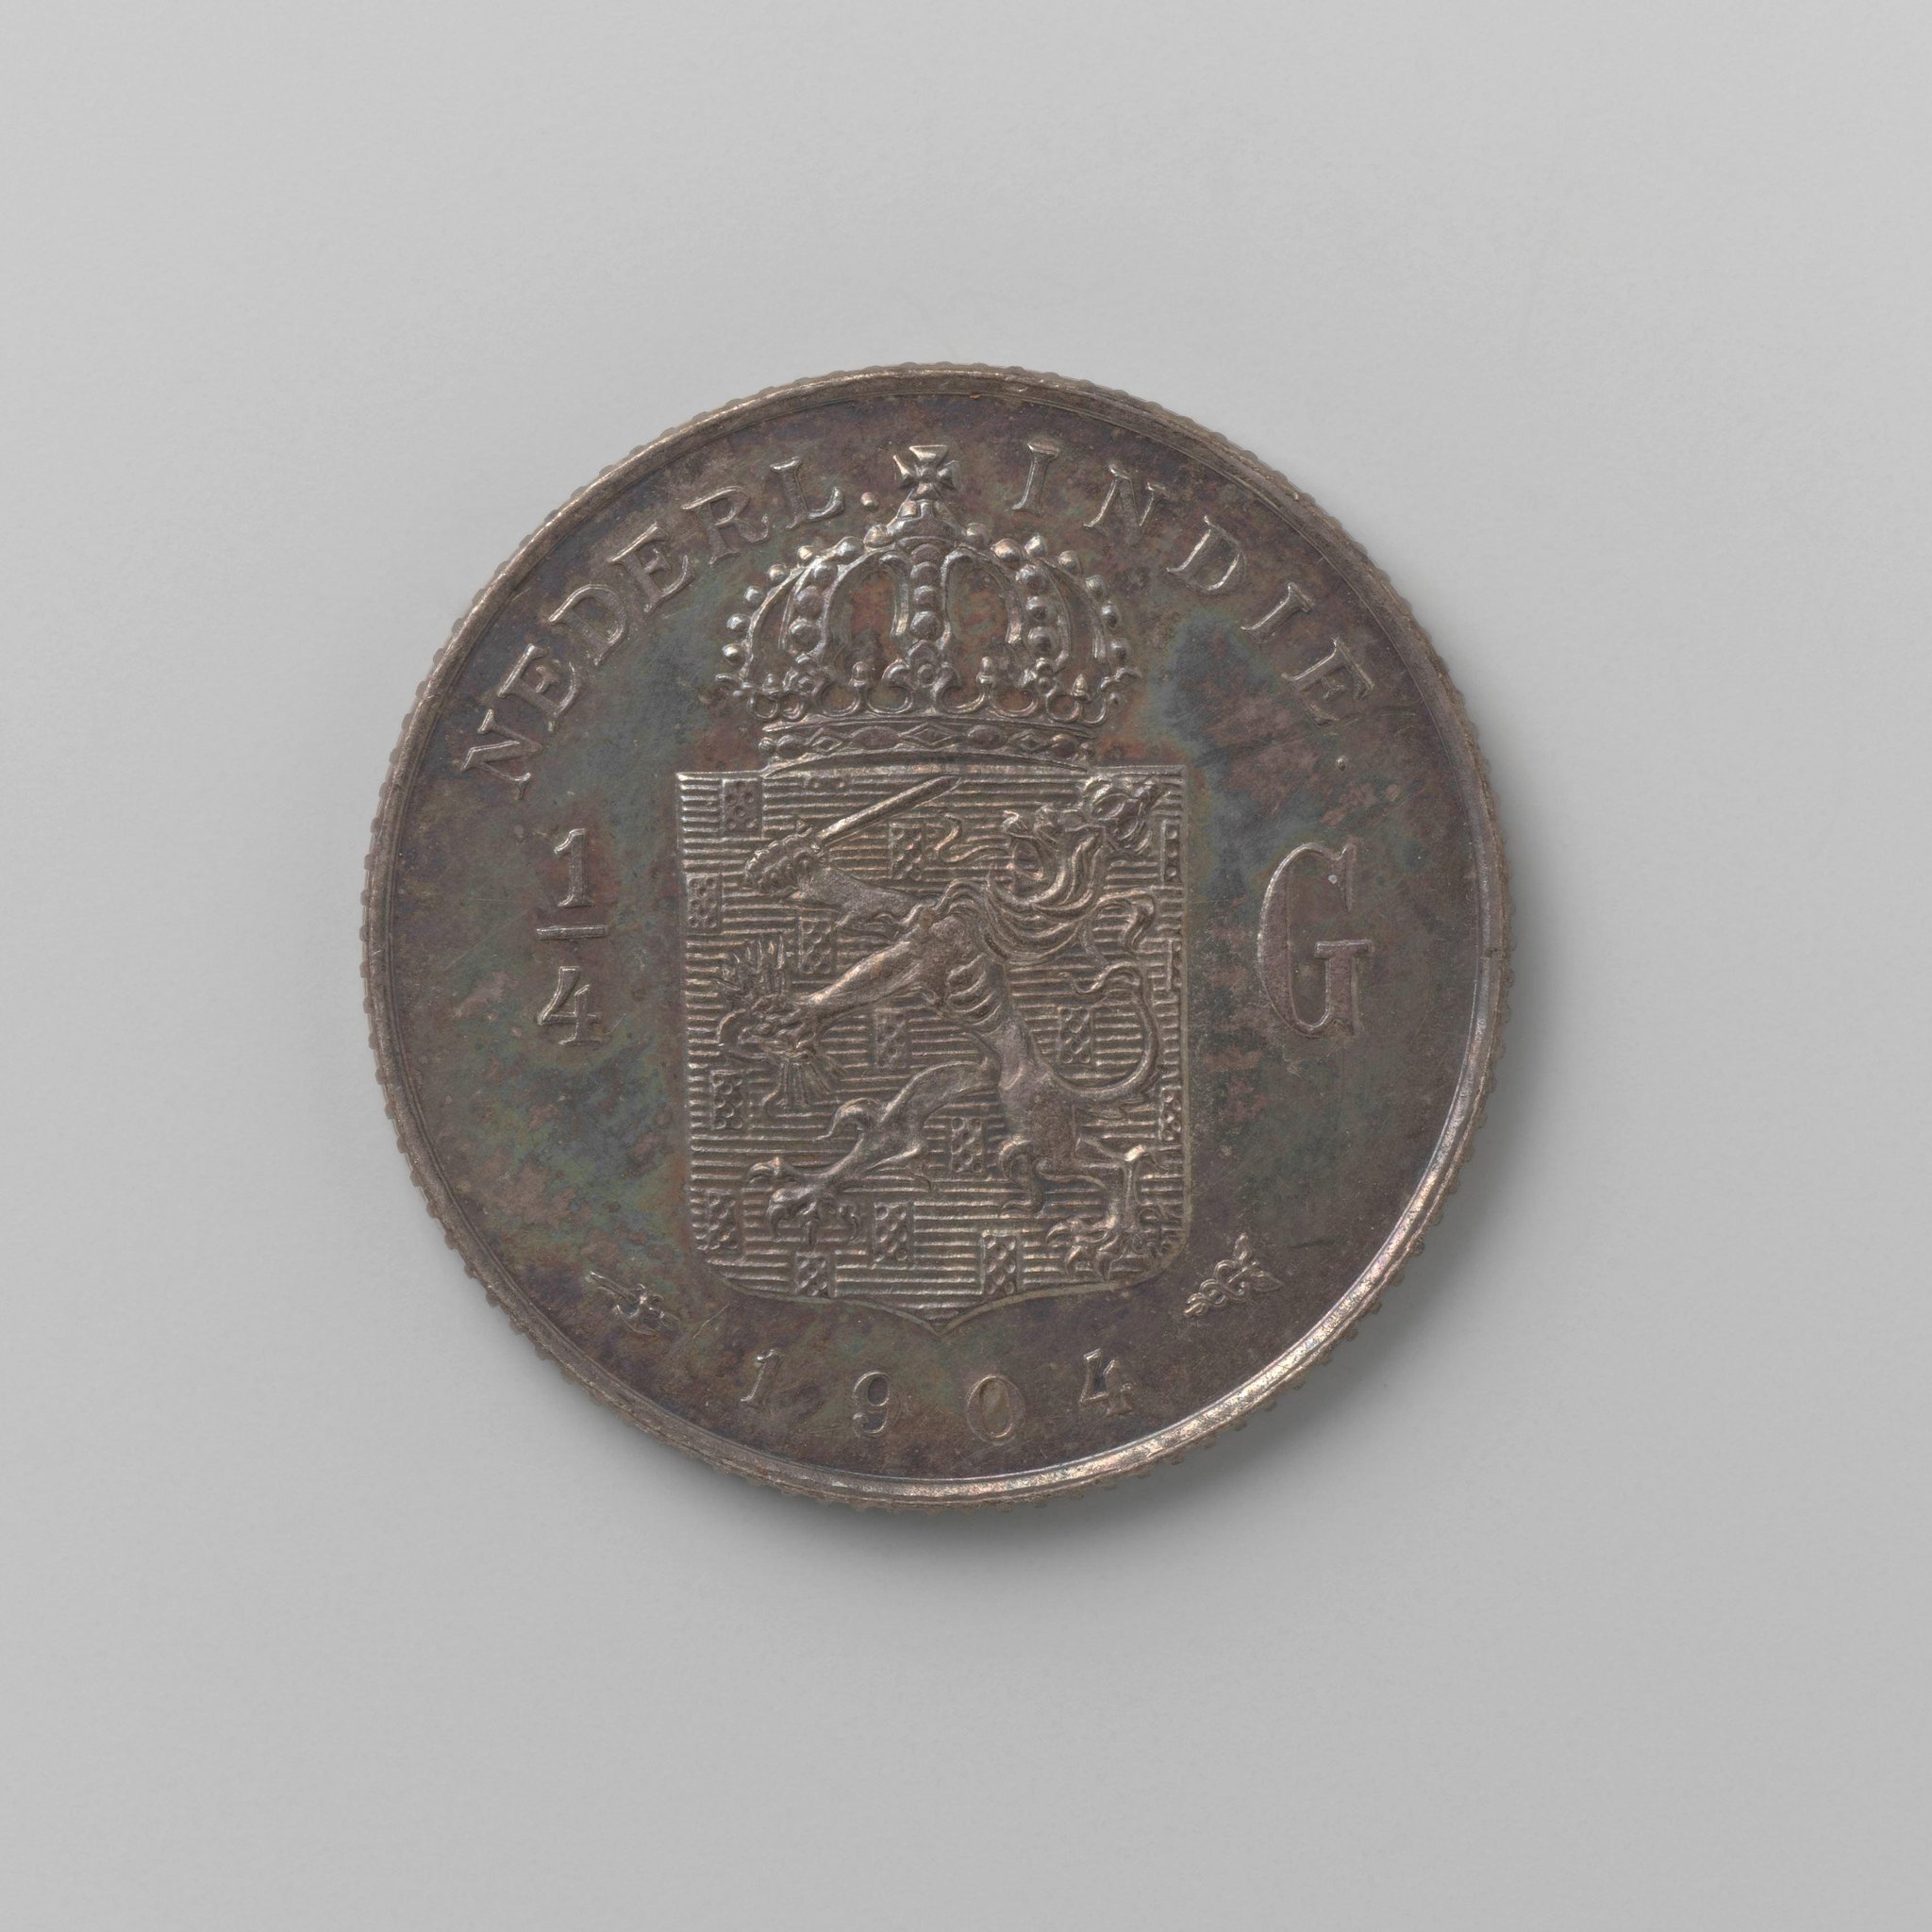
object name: coin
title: 1/4 gulden van Nederlands Indië,1904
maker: wilhelmina of the netherlands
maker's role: print maker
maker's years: 1880-1962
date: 1904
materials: silver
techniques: striking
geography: utrecht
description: Zilveren munt. Voorzijde: tussen waarde-aanduiding 1/4 G gekroond rijkswapenschild. Boven kroon landsaanduiding en onder wapenschild jaartal. Keerzijde: drieregelig Maleis opschrift in Arabische tekens, waaromheen tussen zeven uitschietende stralen omschrift in het Javaans. Kartelrand.